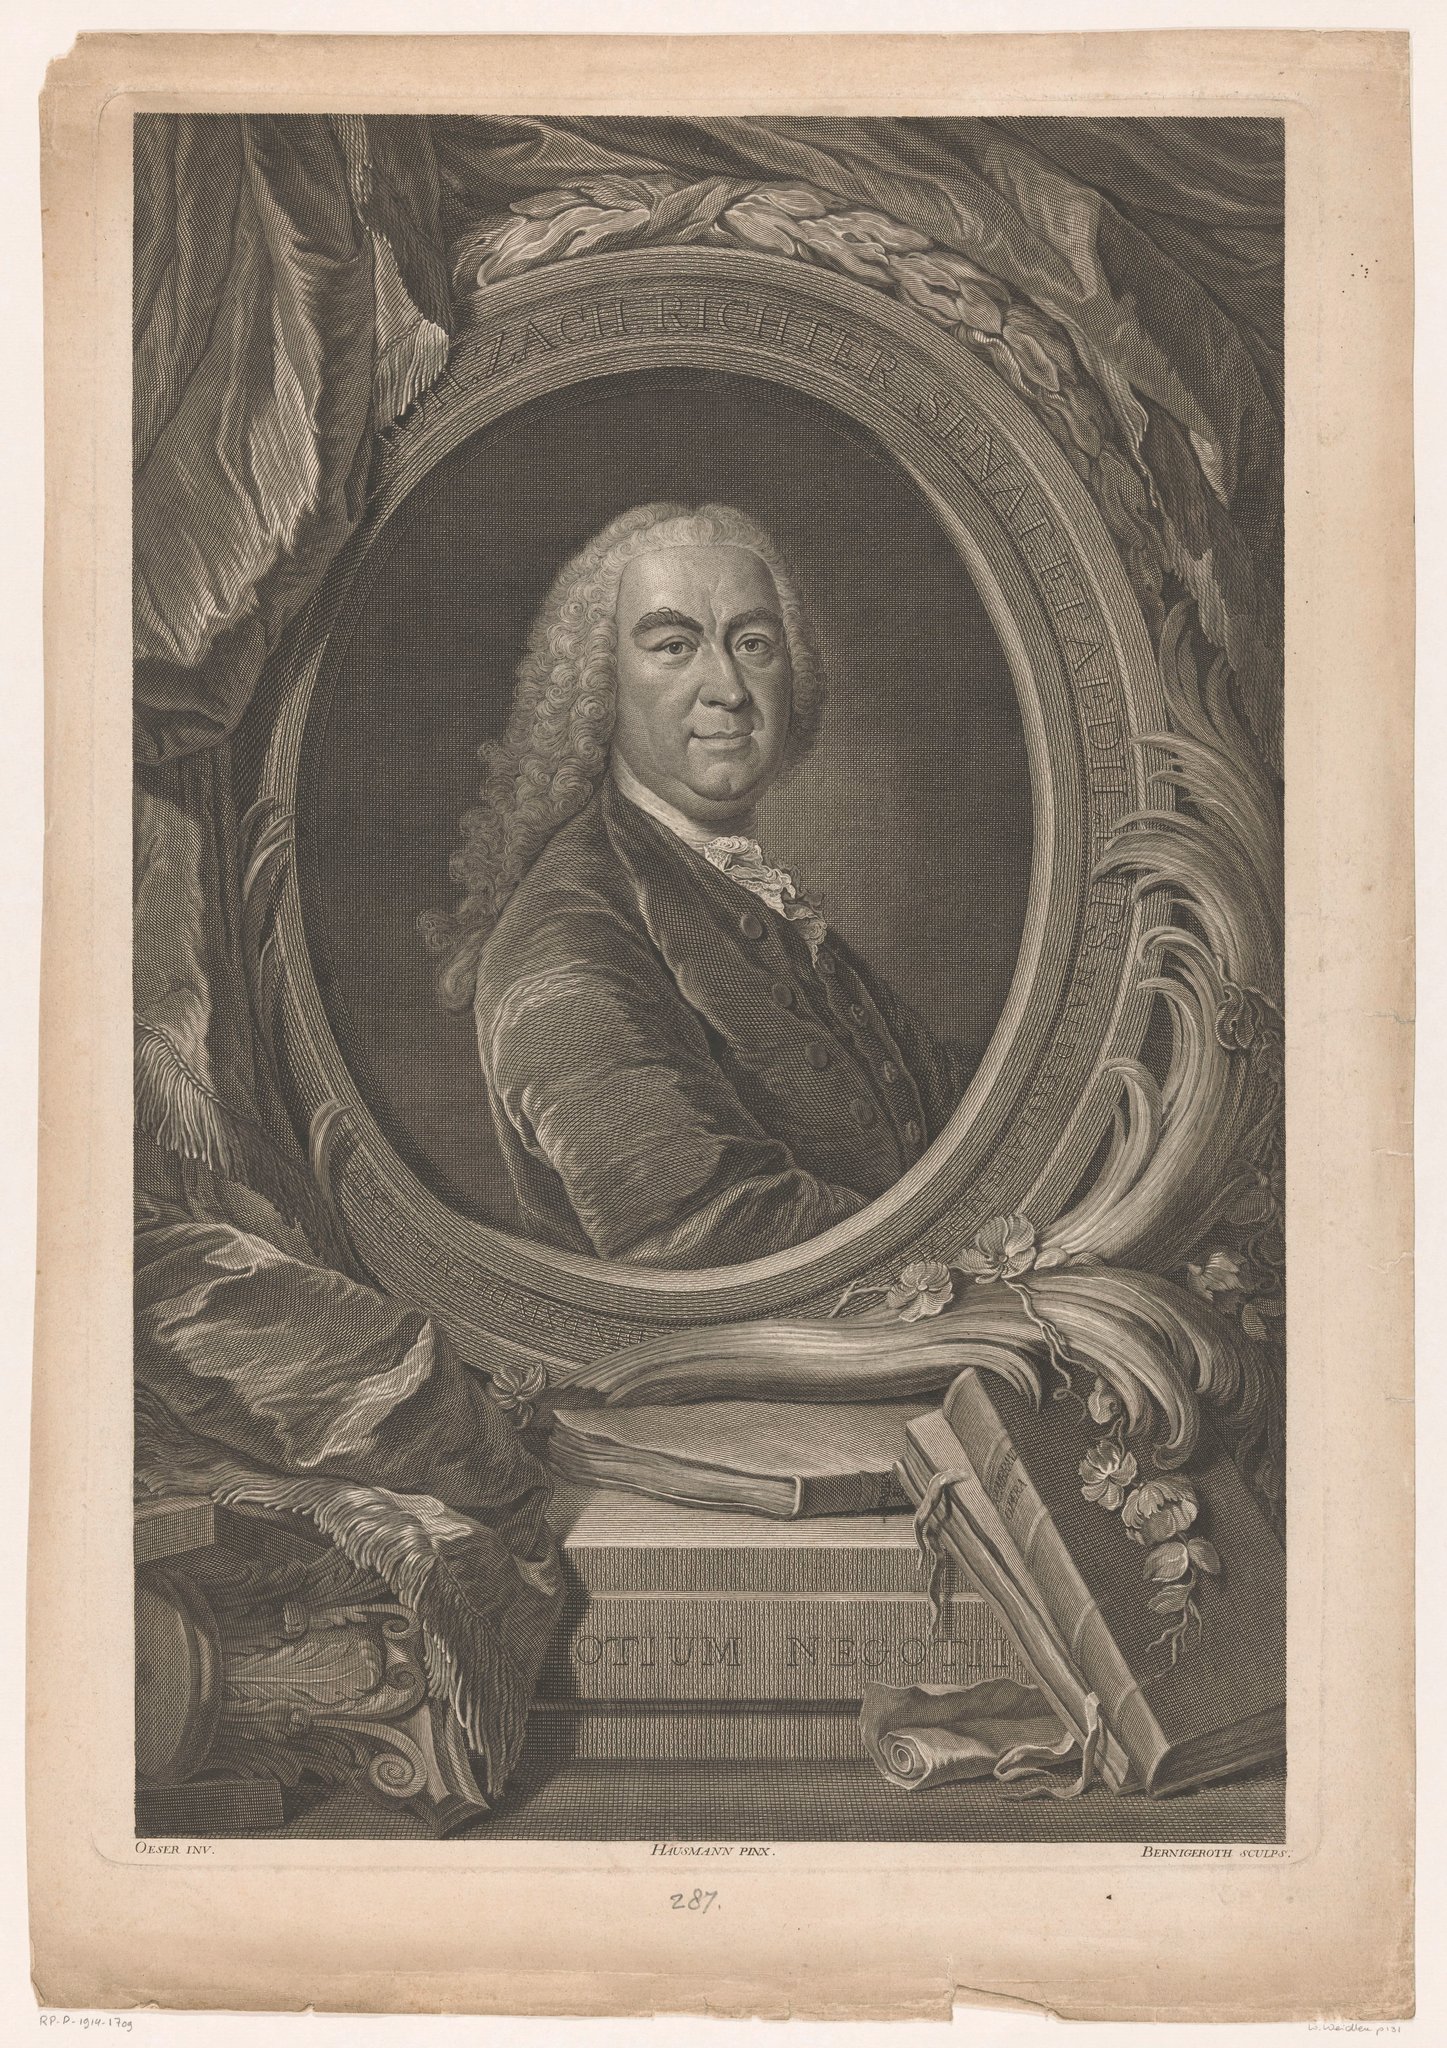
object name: print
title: Portret van Johann Zacharias Richter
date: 1764-1767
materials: paper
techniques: engraving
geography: leipzig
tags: historical persons, book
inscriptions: collector's mark: Lugt 2228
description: Naast koopman en raadsheer was Johann Zacharias Richter ook kunstliefhebber. Op de voorgrond ligt een boek met de titel 'Rembrandt Opera'. Daarachter een boek met de titel 'Raphael'.